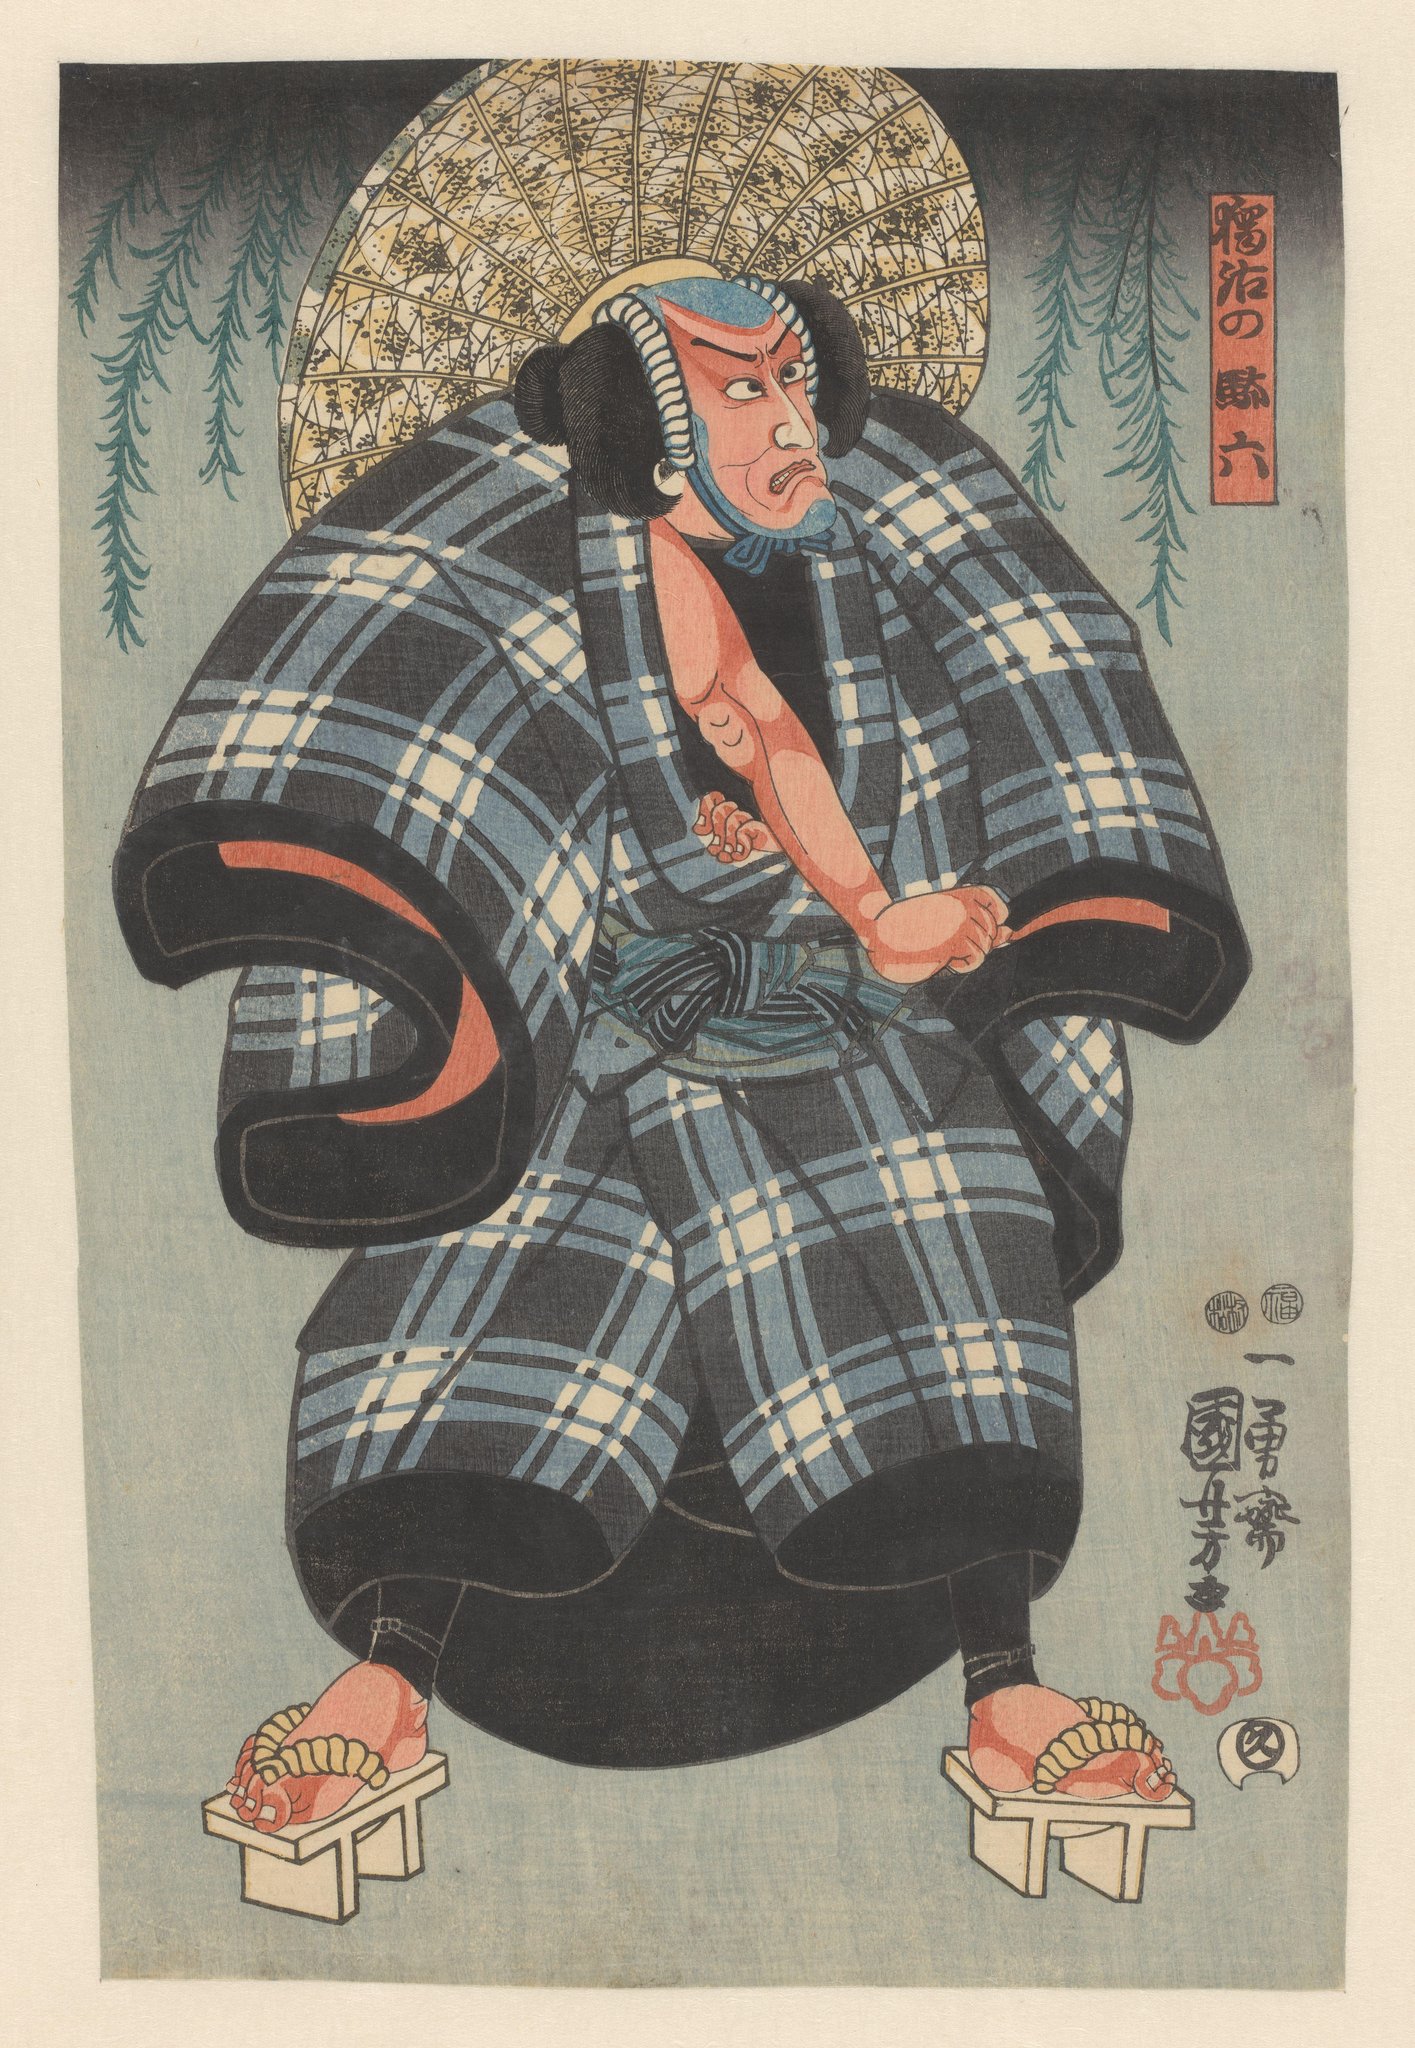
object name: print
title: Daroku no Daraku near willow branches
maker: utagawa kuniyoshi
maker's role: draughtsman, print maker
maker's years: 1798-1861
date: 1851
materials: paper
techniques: woodcut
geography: japan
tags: head-gear, portrait of actor, actress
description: De timmerman Dokko no Daroku, gespeeld door kabuki acteur Ichikawa Ebizô V, met blauw geruite mantel en brede hoed op zijn rug, ten voeten uit afgebeeld onder wilgentakken.